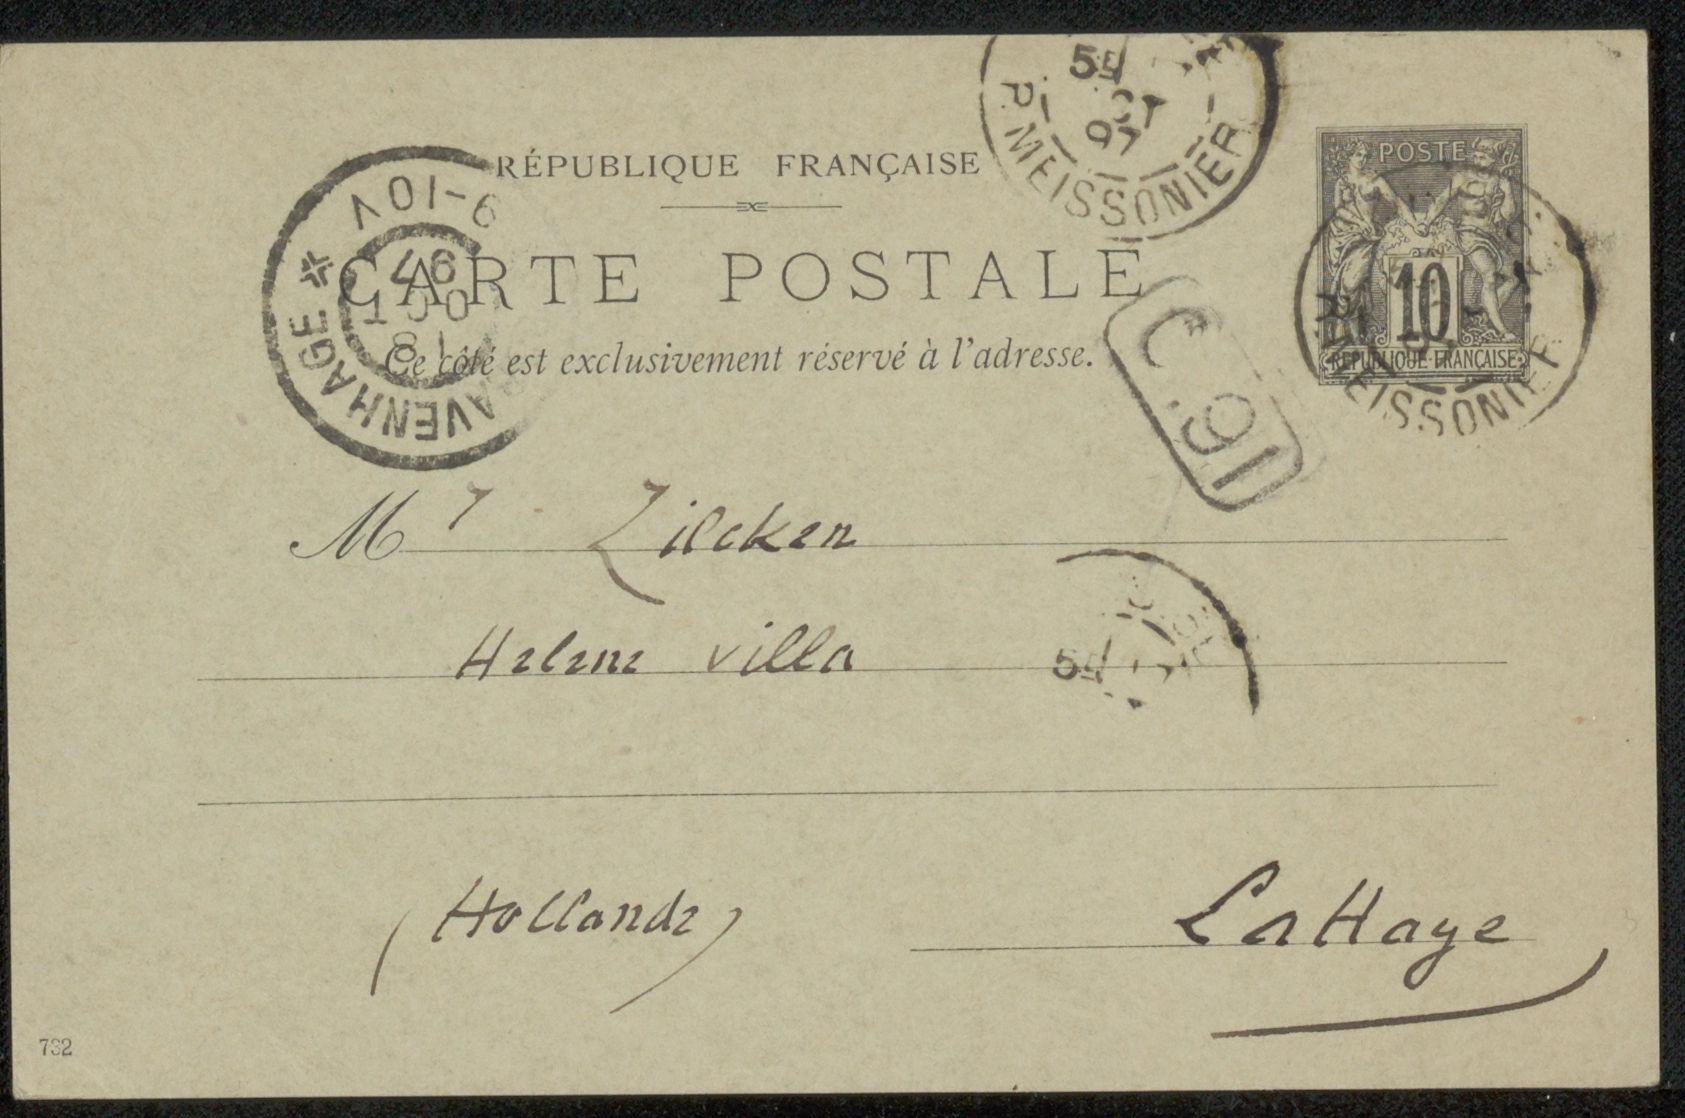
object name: postcard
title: Briefkaart aan Philip Zilcken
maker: georges rodenbach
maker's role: dichter, schrijver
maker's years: 1855-1898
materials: cardboard, ink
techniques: pen, writing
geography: paris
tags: the hague, draughtsman, philip zilcken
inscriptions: collector's mark: ‘RPK’